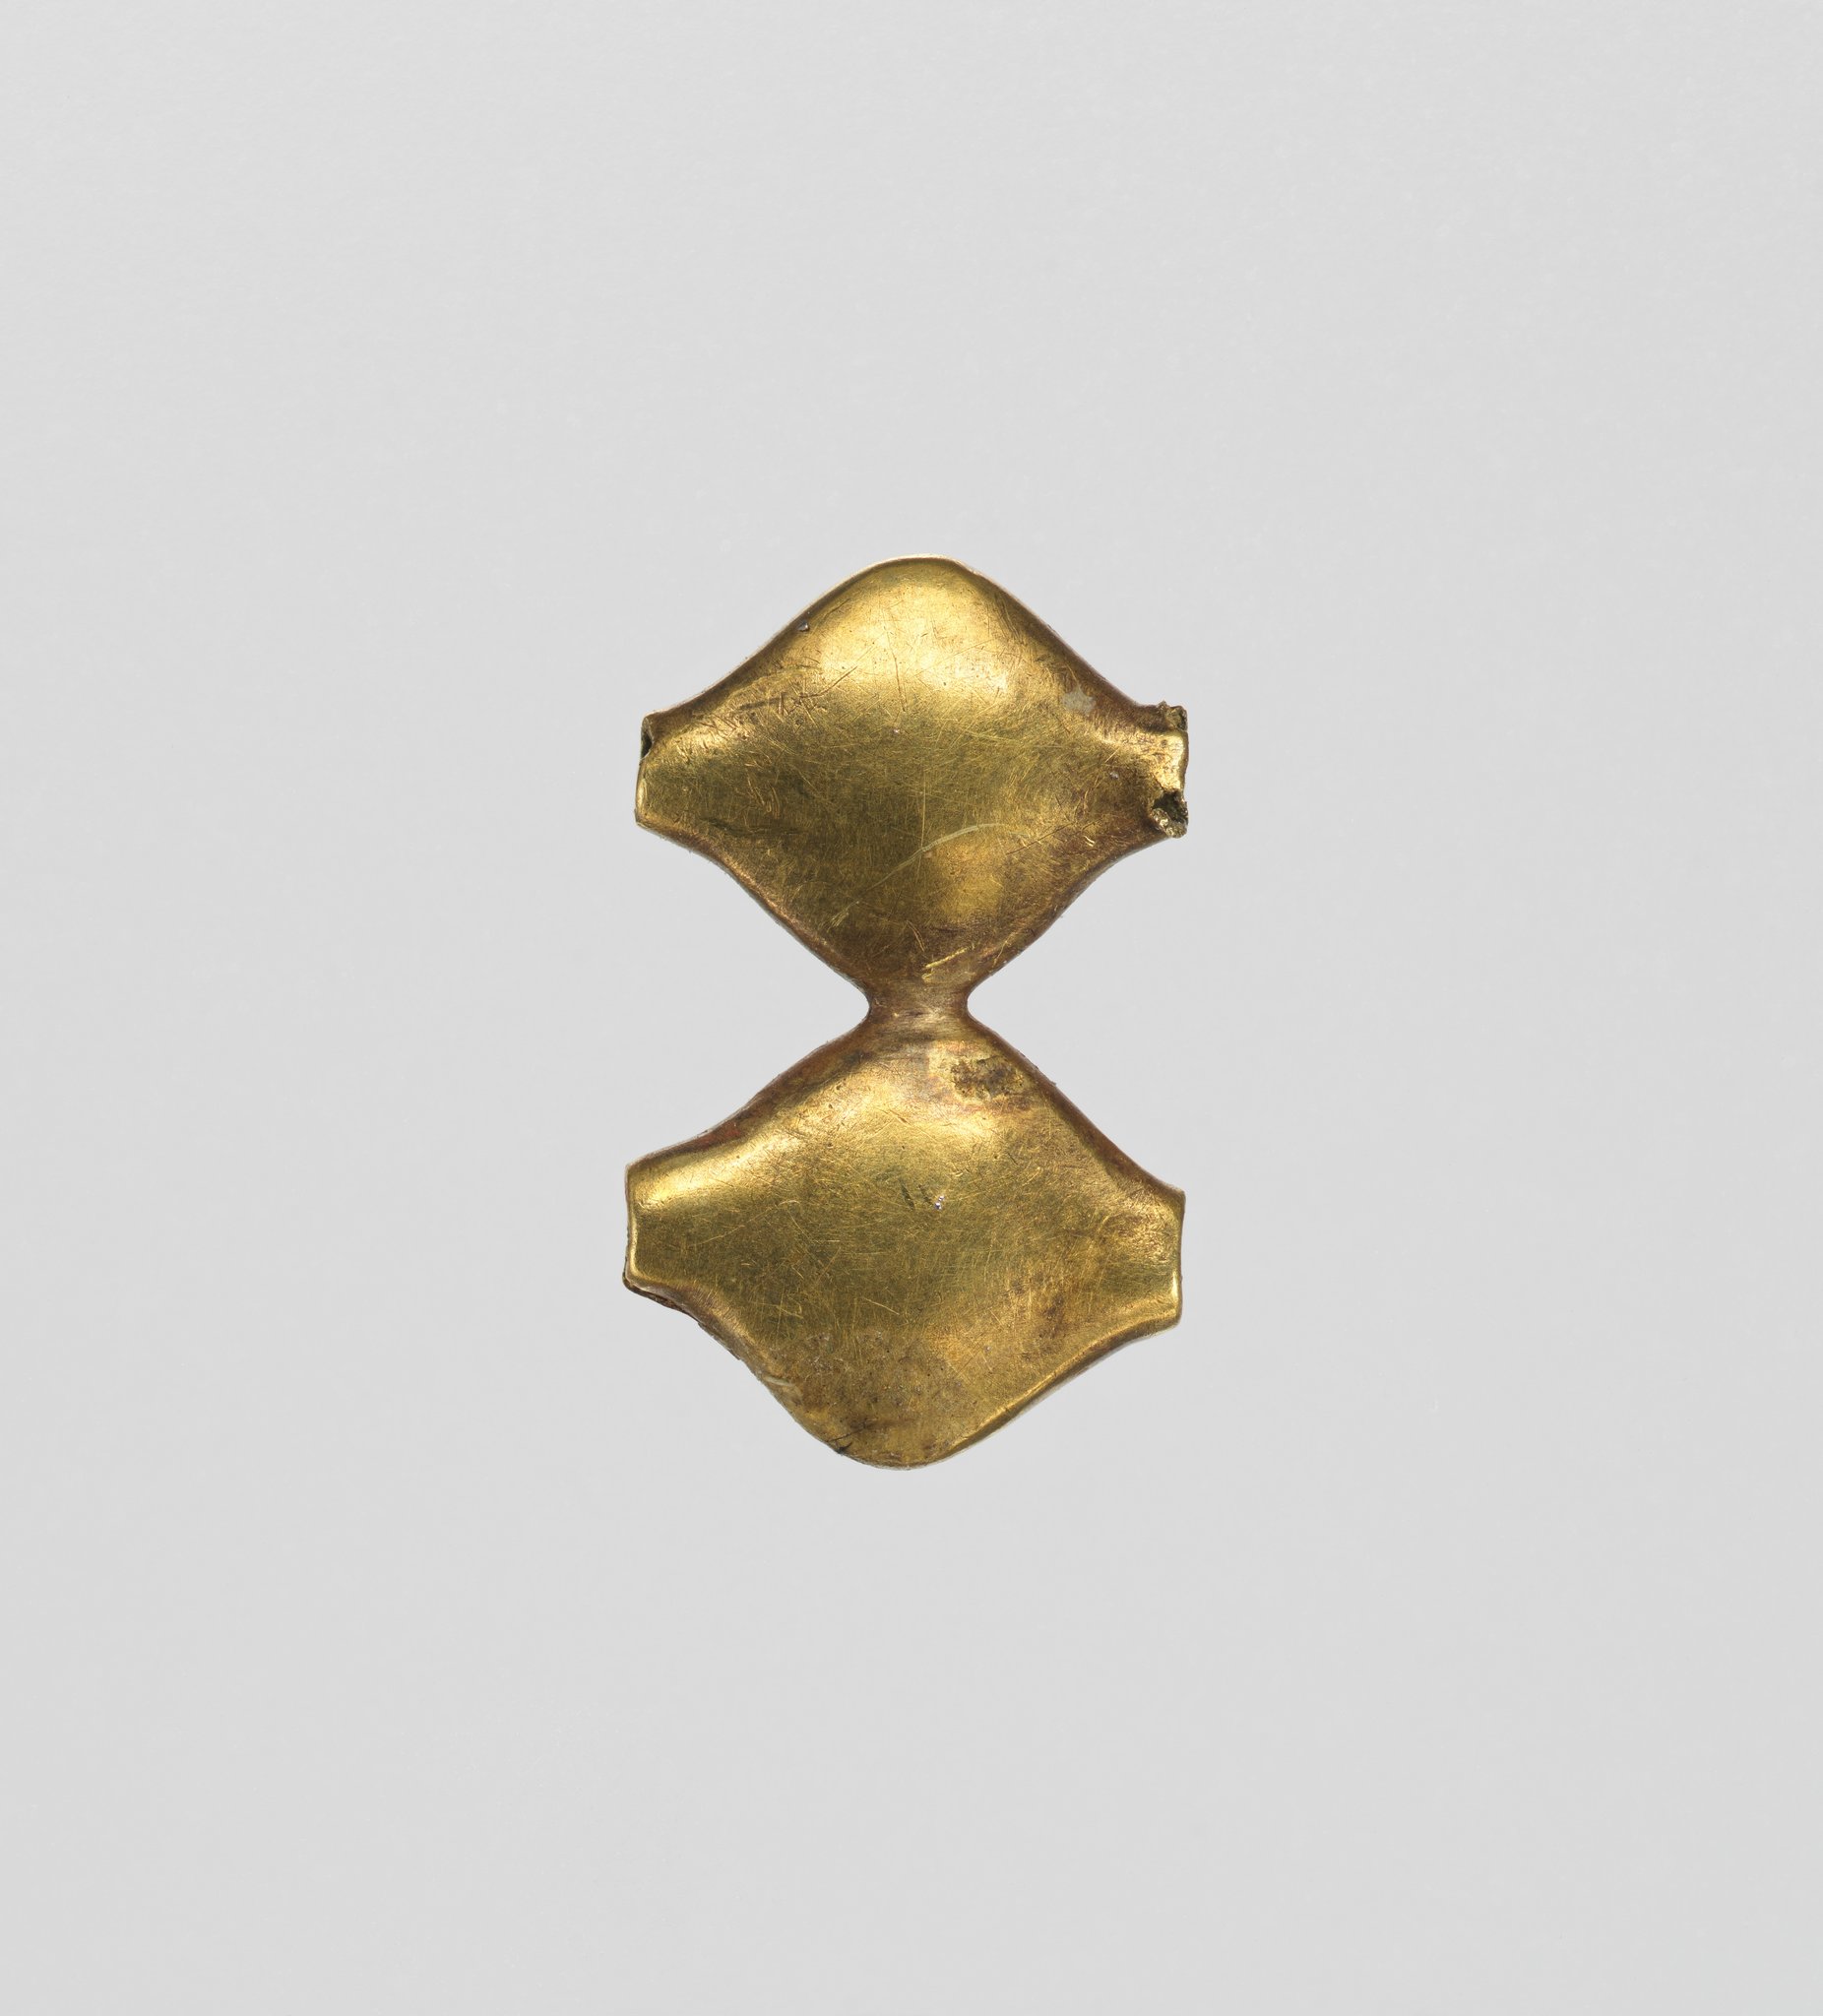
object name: bead, acacia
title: Two acacia seed beads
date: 1878-1840 BCE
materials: gold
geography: memphite region